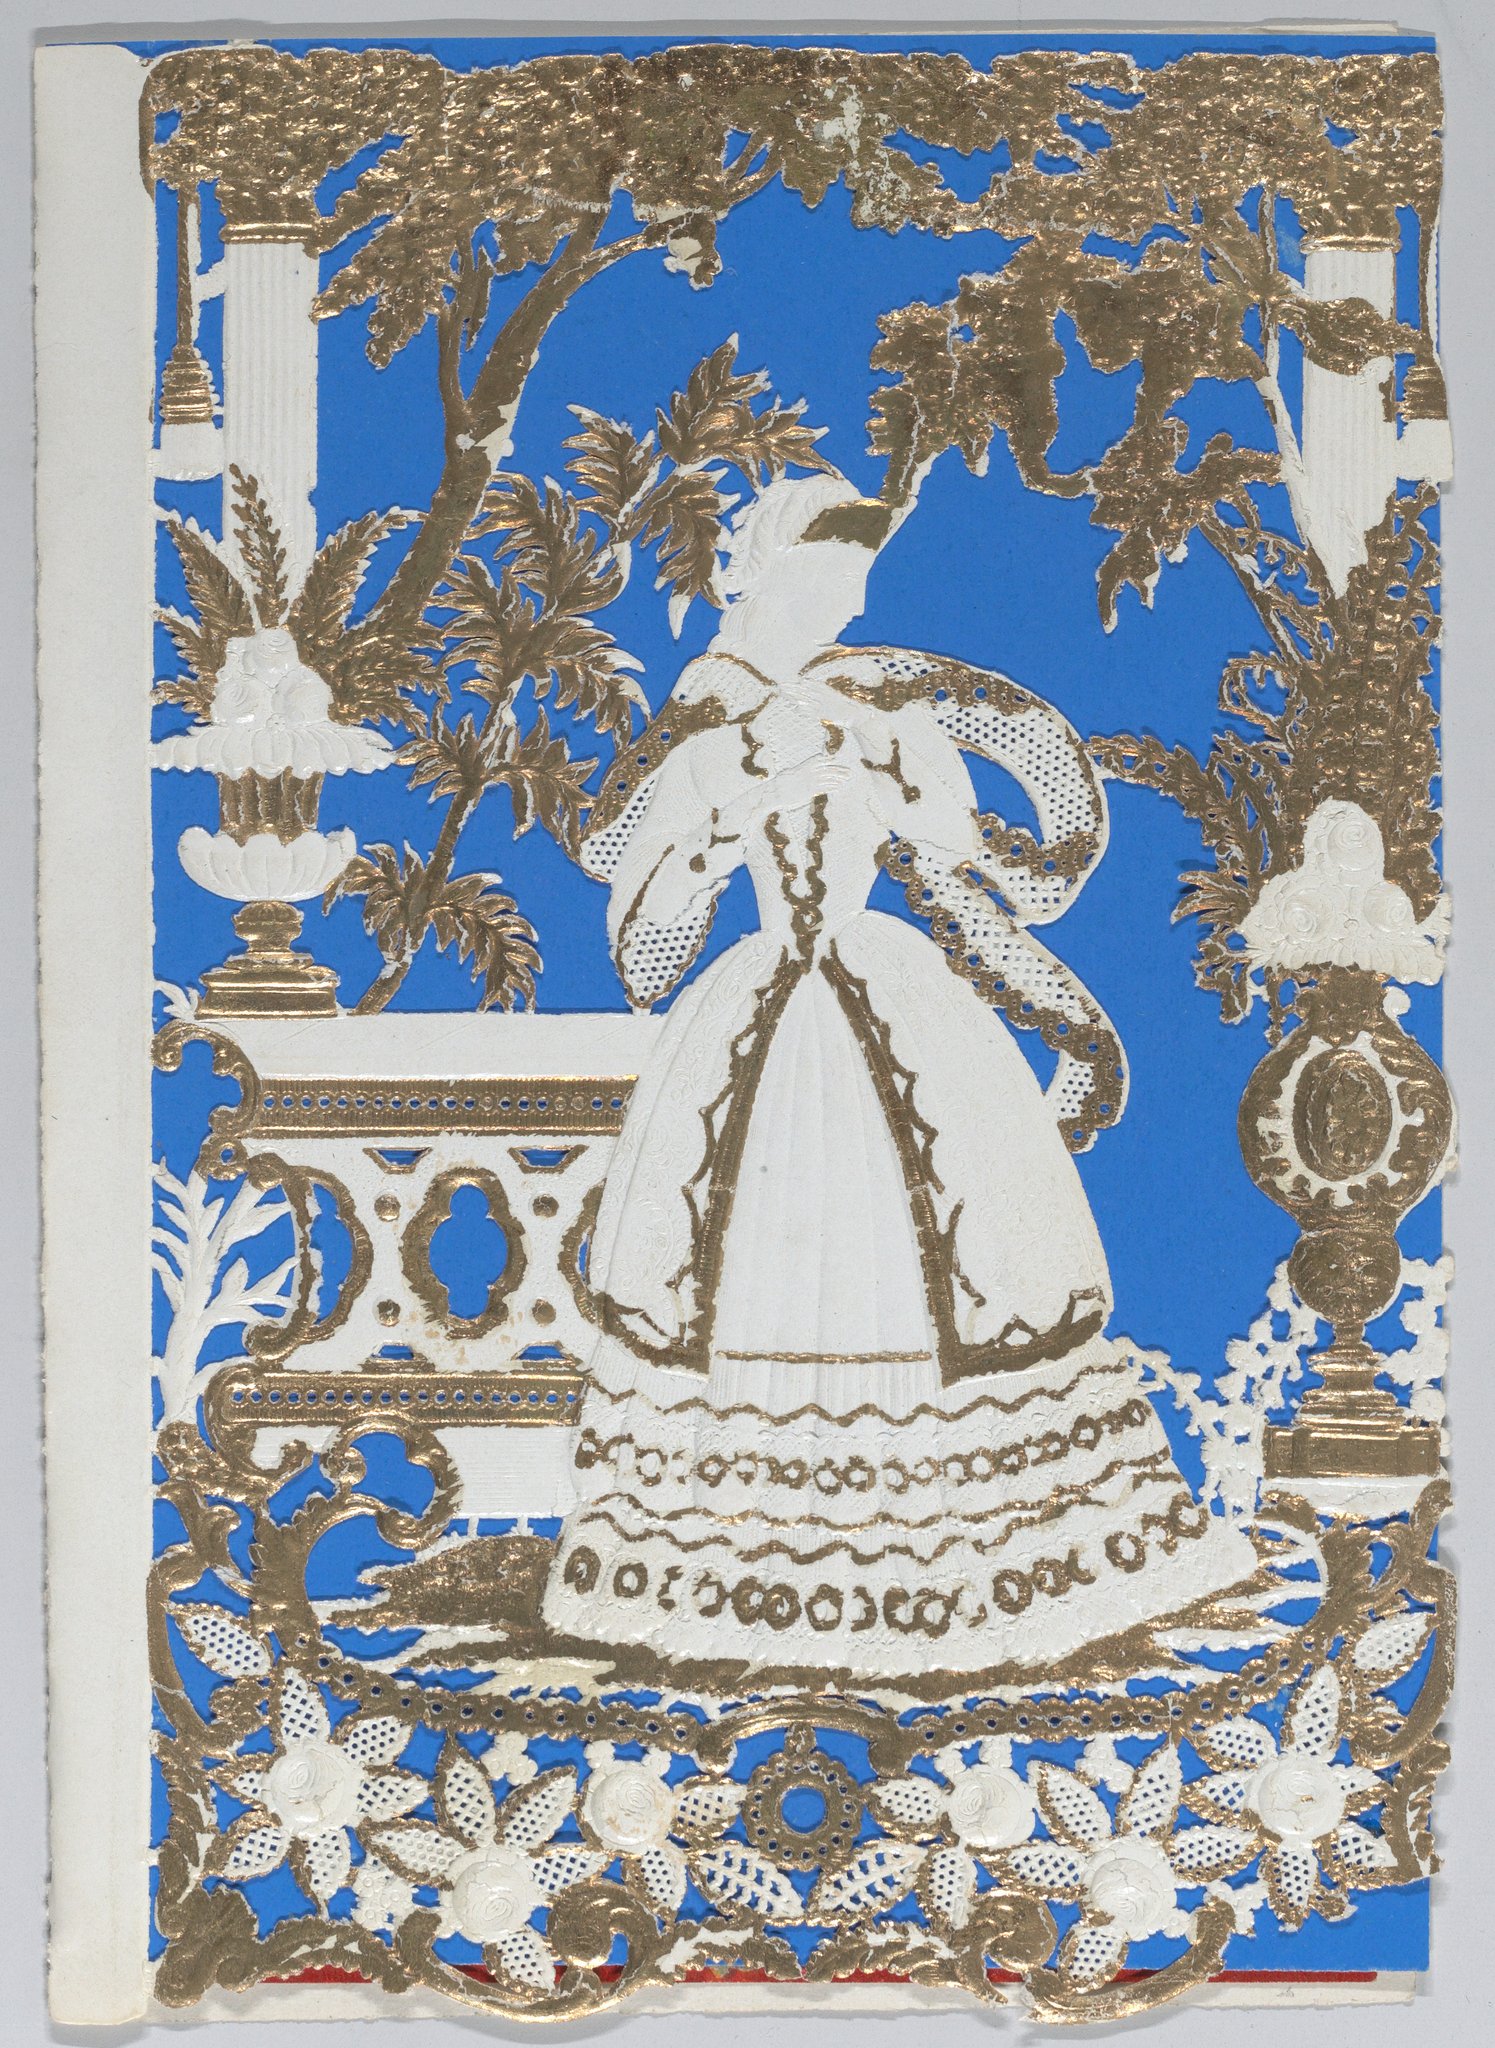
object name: valentine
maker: Anonymous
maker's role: artist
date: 1880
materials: lace, paper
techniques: chromolithography, embossing, gilding, open work